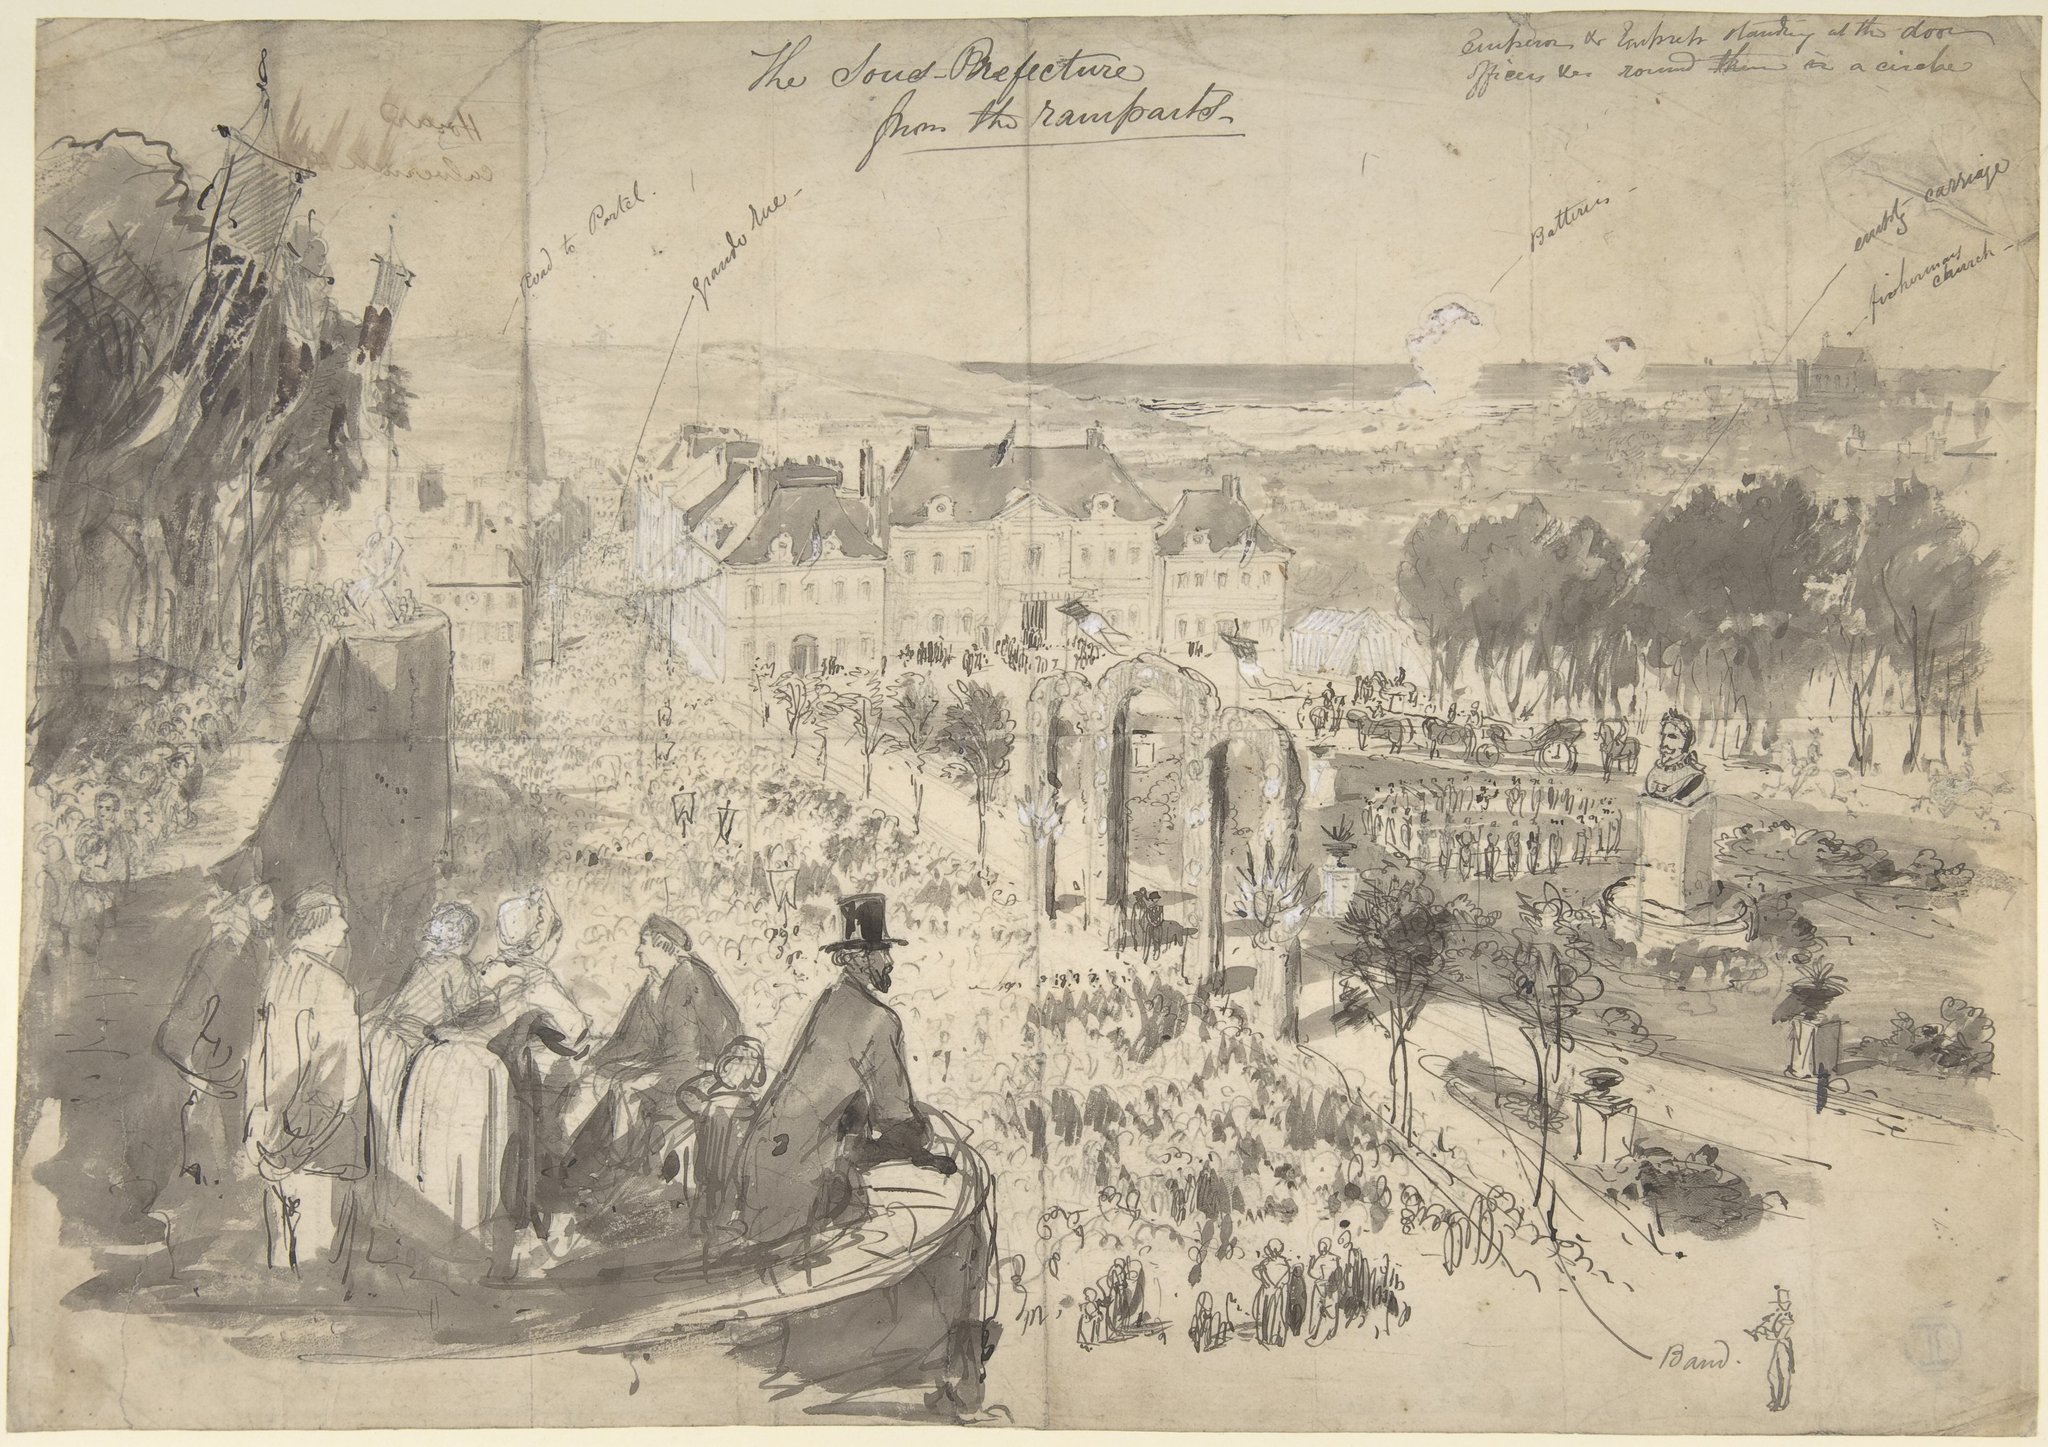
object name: drawing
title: The Visit of Napoléon III to Boulogne-sur-Mer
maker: constantin guys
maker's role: artist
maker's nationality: french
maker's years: 1802-1892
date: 1801-1900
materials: gouache, graphite, ink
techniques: heightening, pen, wash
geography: france